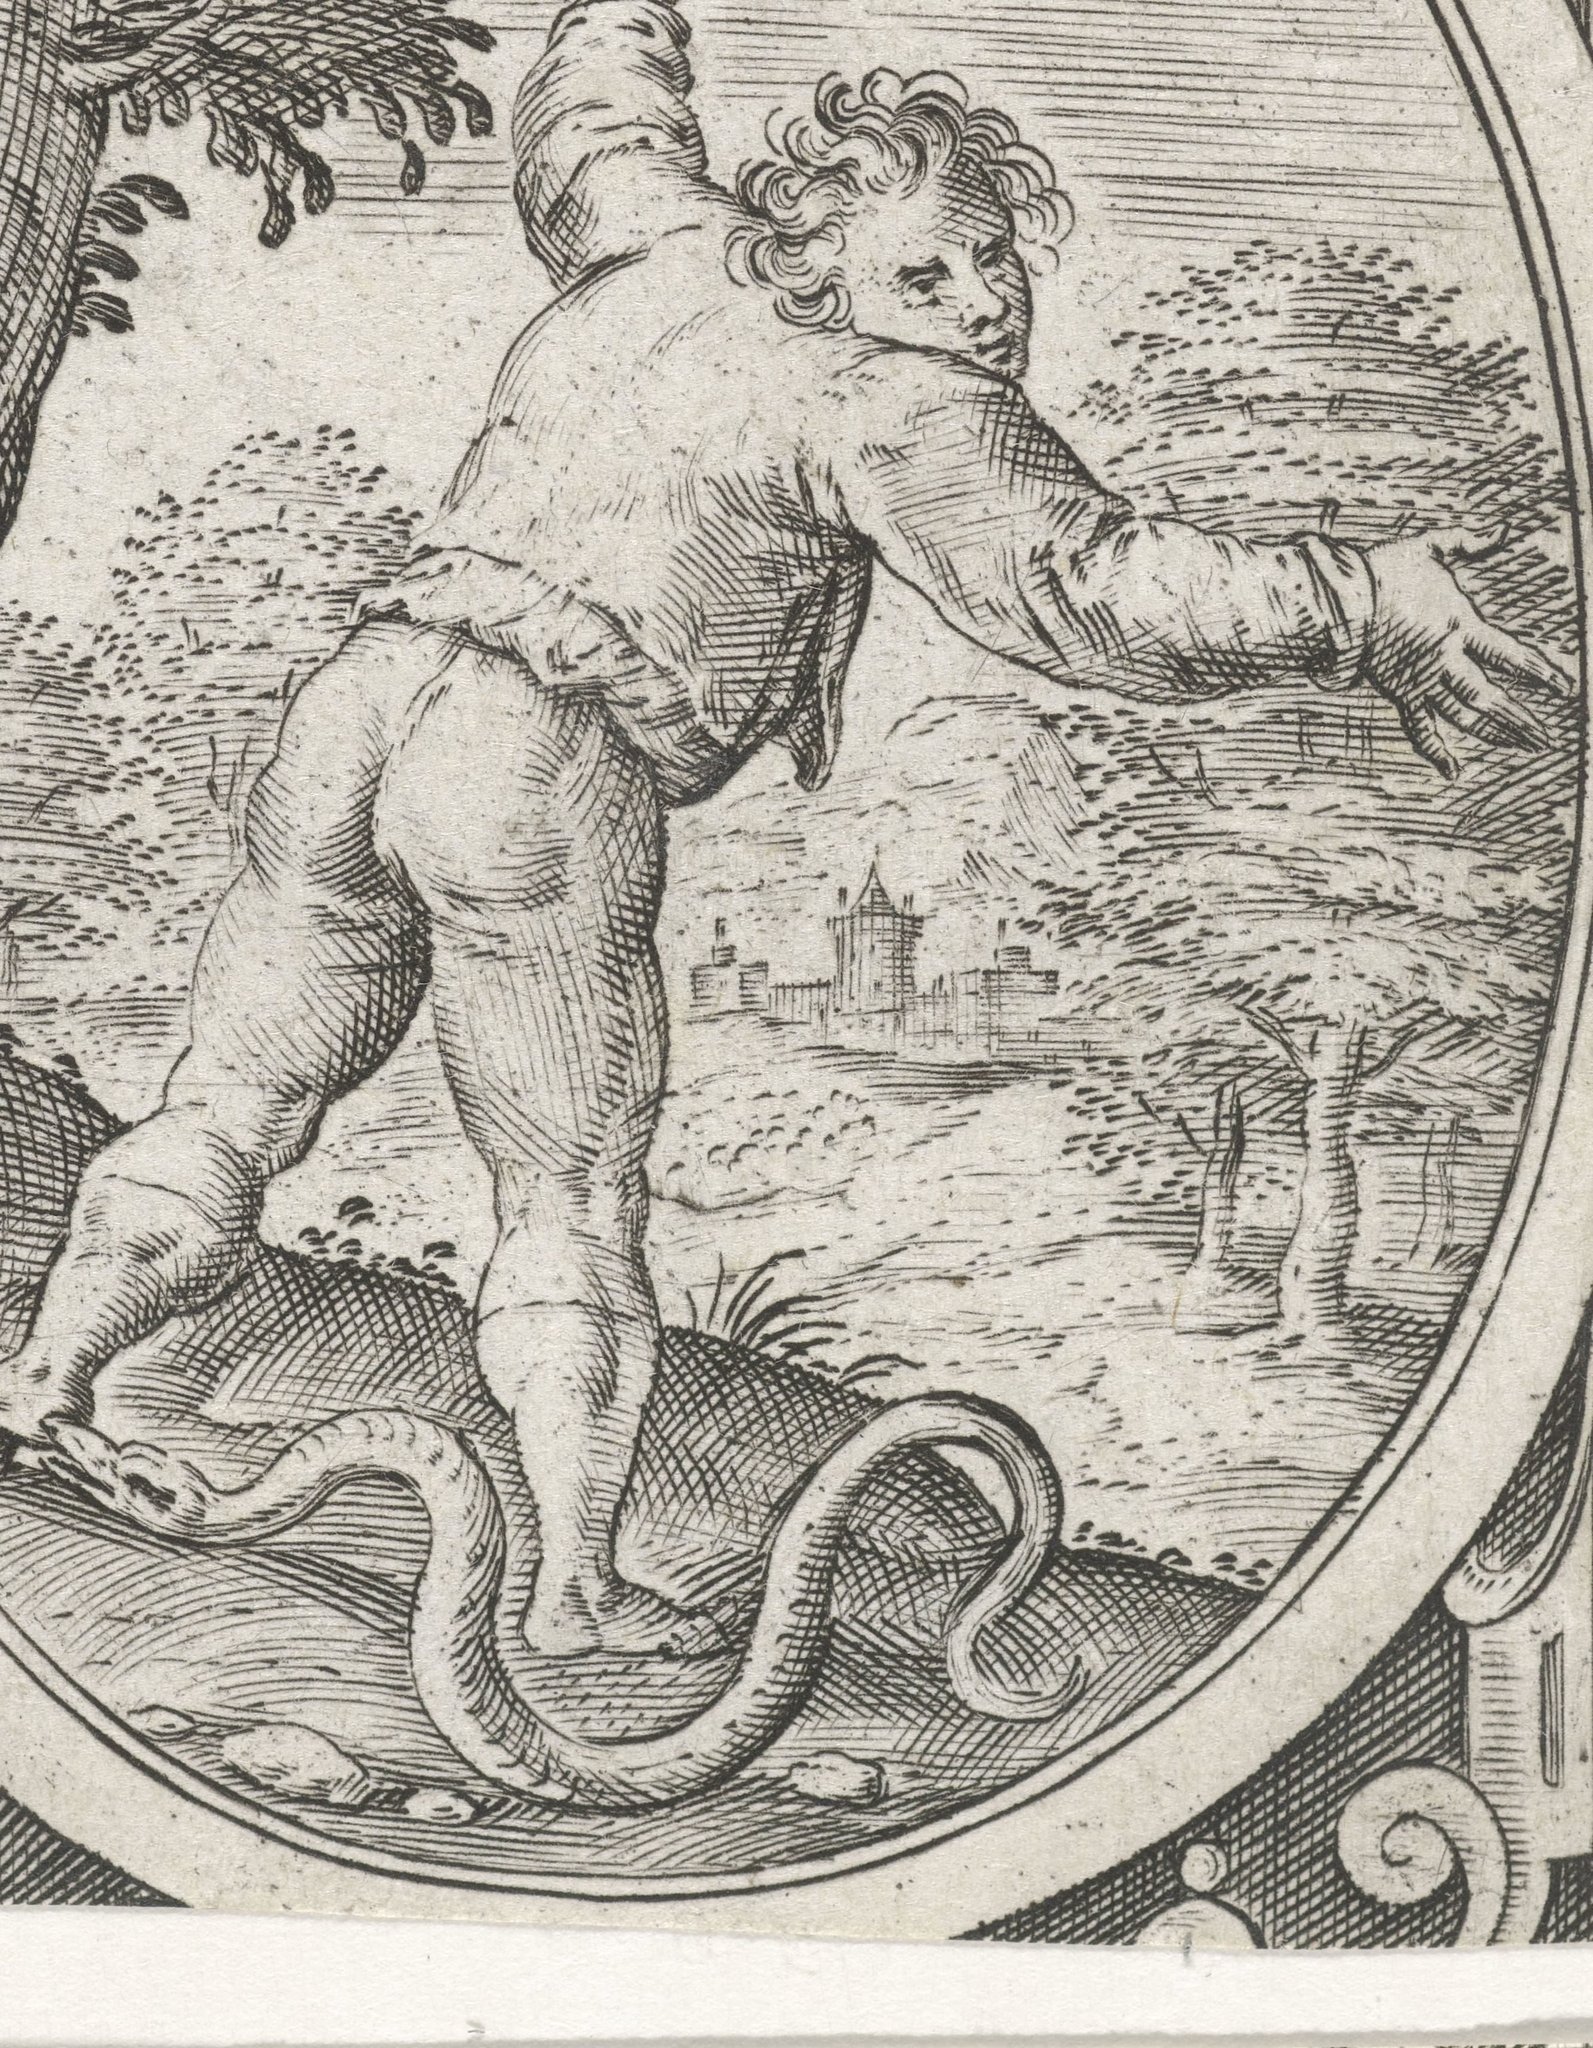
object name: print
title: Gnomae seu sententiae vitae utiles ex ecclesiastico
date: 1547-1591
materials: paper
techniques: engraving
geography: antwerp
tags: the book of ecclesiasticus, the wisdom of jesus sirach (with book chapter:verse)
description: Ornamentele omlijsting met medaillon waarin een landschap met een man, op de rug gezien. Hij wordt in zijn hiel gebeten door een slang. Uit Sir. 21:2: 'Vlucht voor zonden als voor een slang, want als de zonde naderbij komt grijpt ze je. Haar tanden zijn als die van een leeuw, ze rukken mensenlevens weg.'